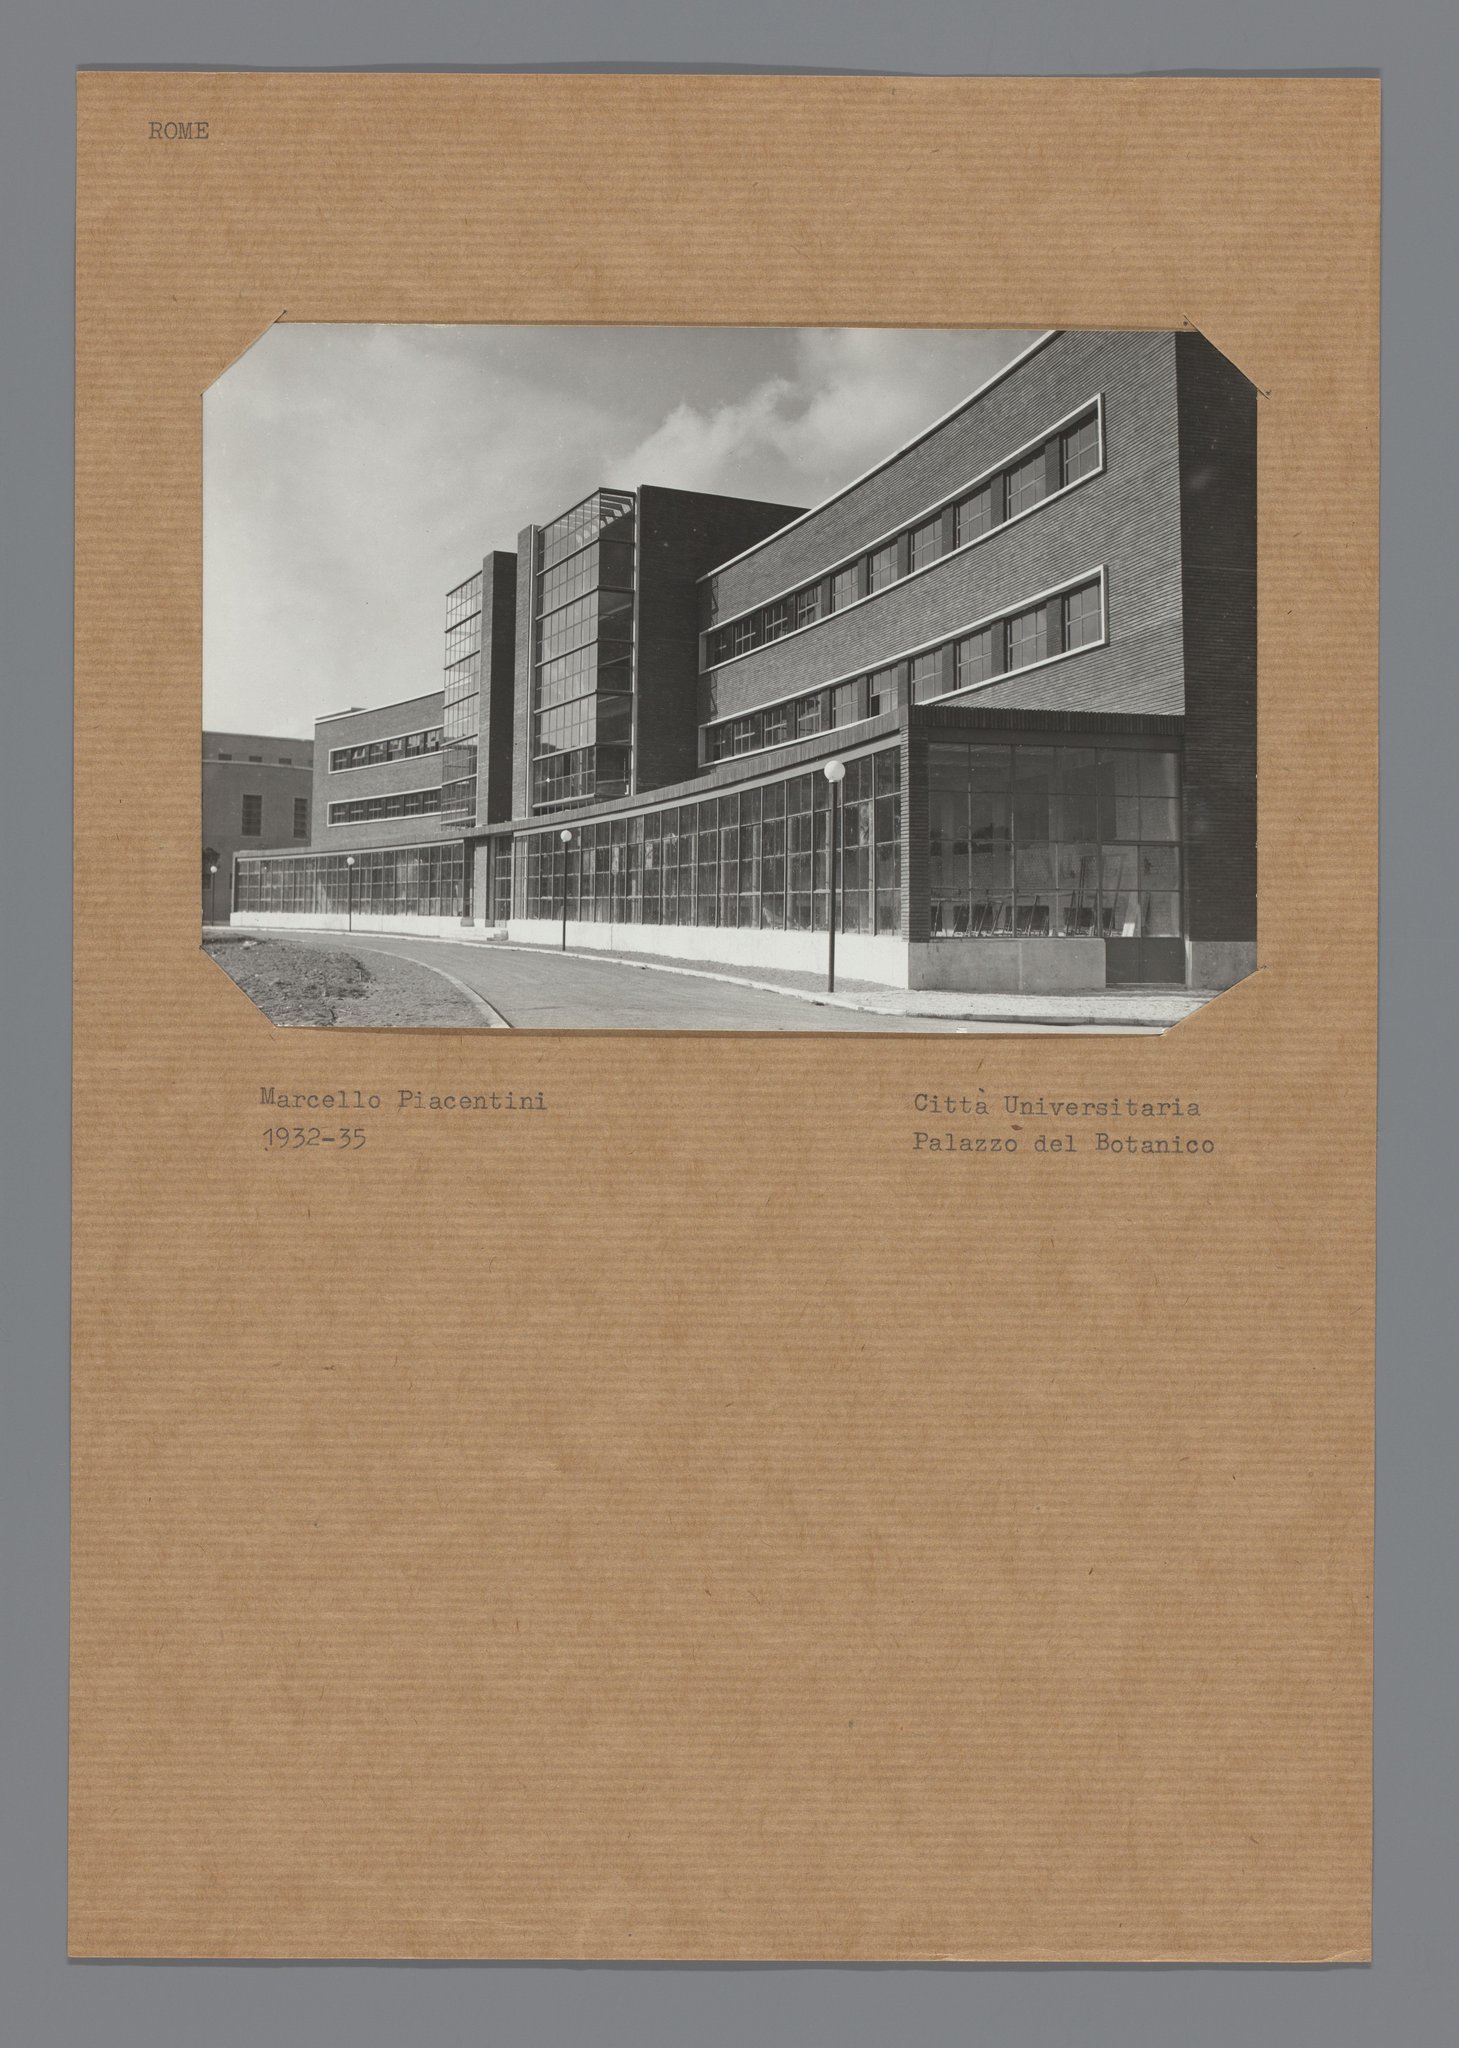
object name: photograph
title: Italië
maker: Anonymous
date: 1880-1910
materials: photographic support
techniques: albumen print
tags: italy